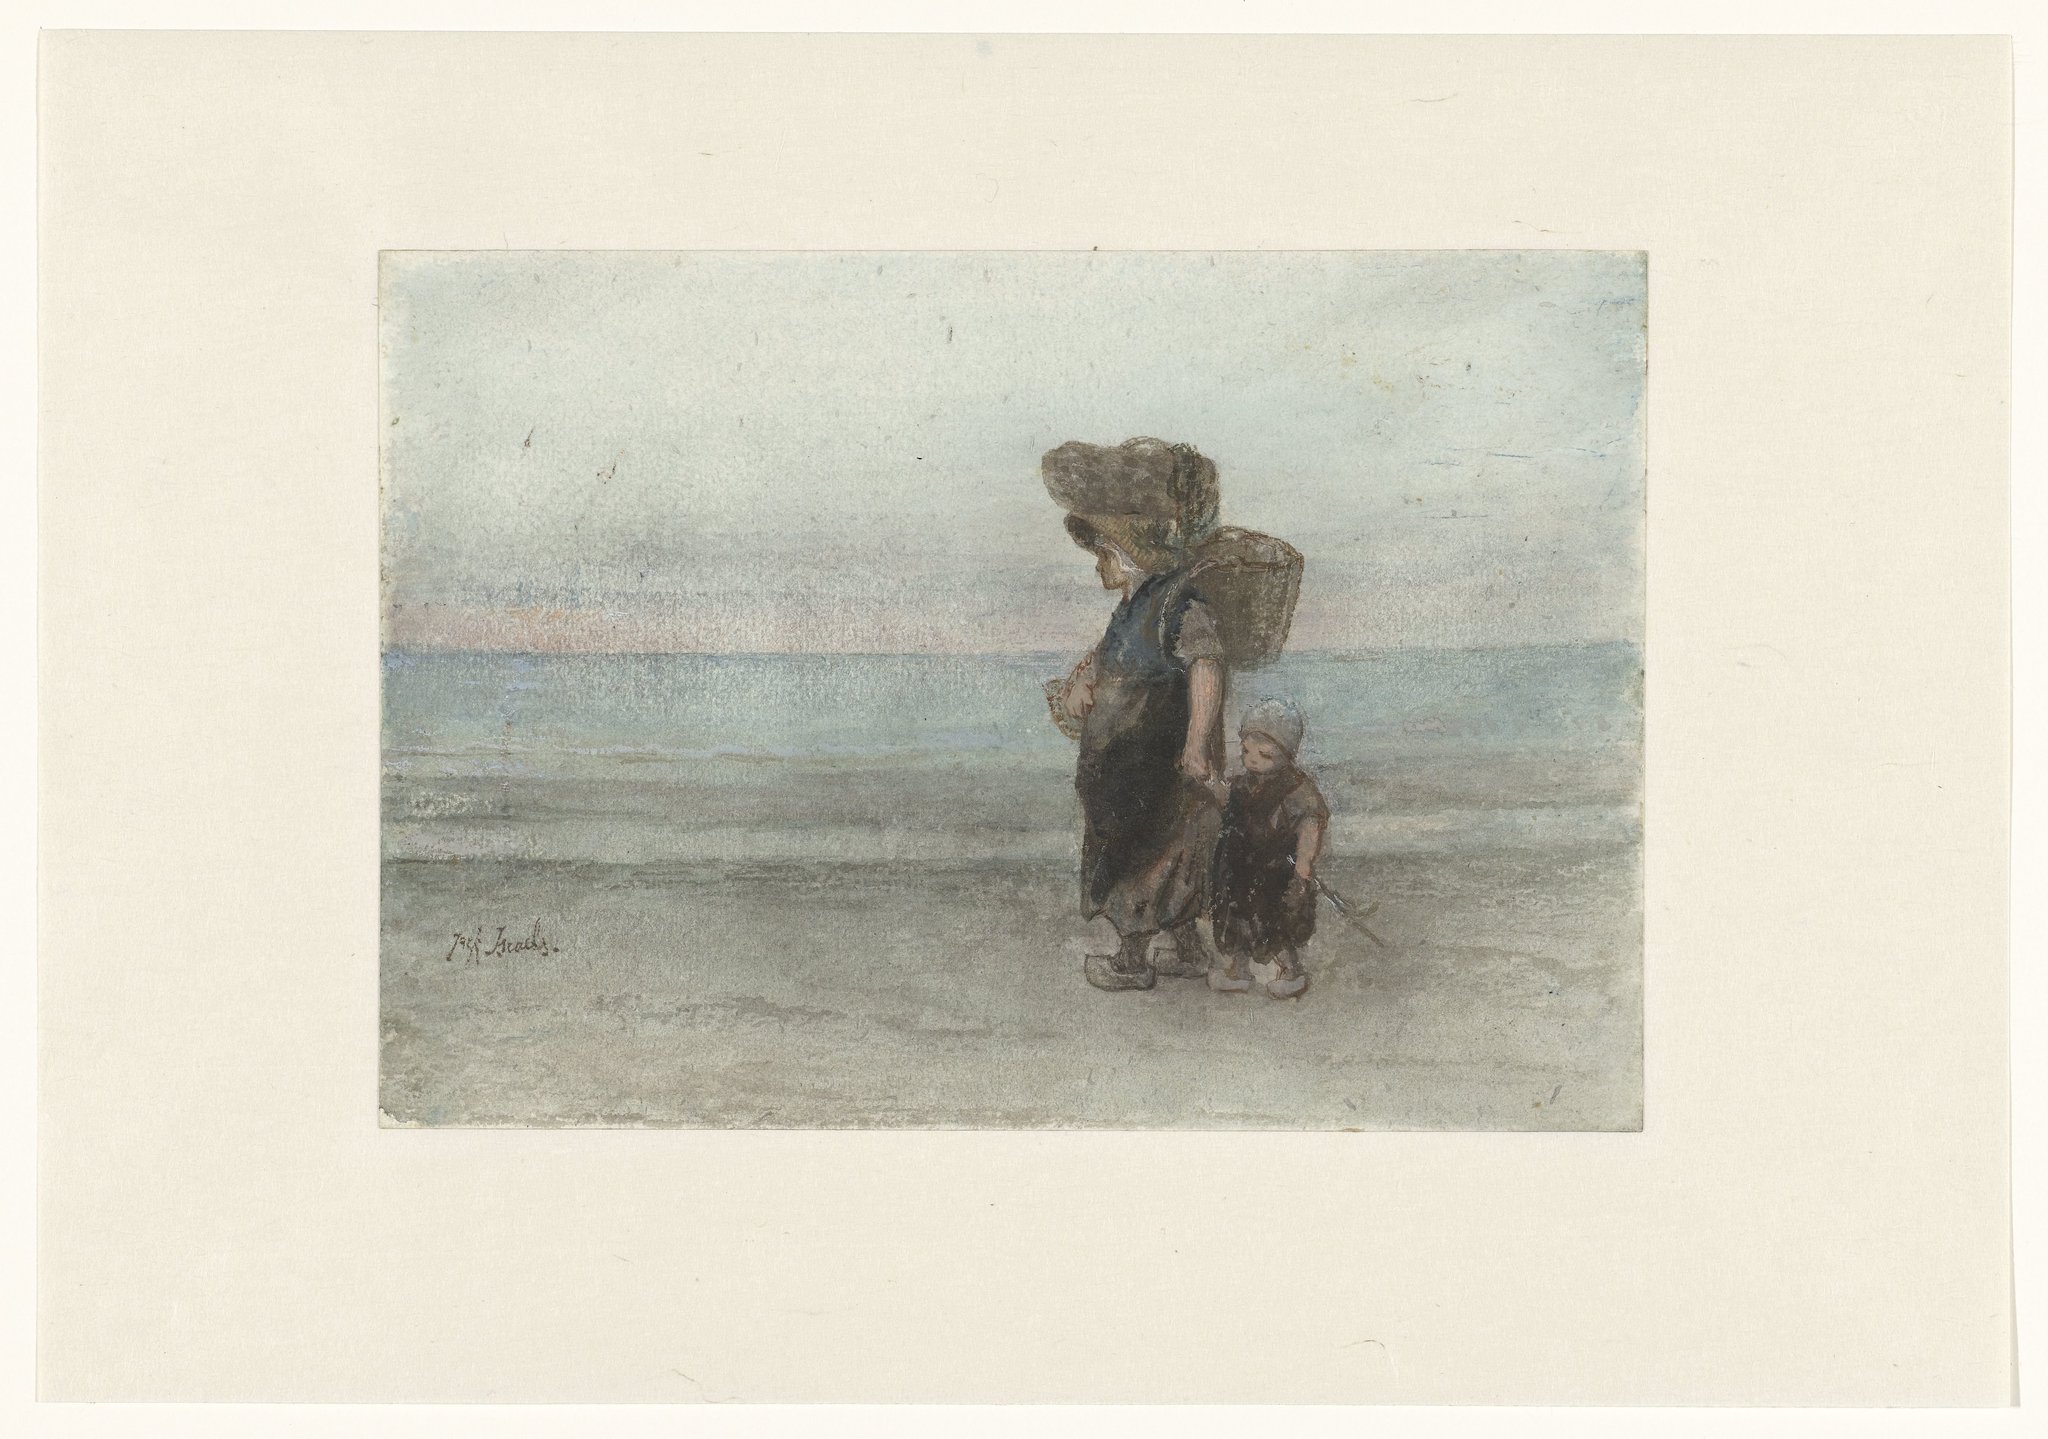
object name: watercolor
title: Vrouw met kind, lopend over het strand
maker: jozef israëls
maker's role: draughtsman, painter, print maker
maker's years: 1824-1911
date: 1834-1892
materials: ink, paper, pencil, watercolor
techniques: brush, pen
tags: mother and baby or young child, beach